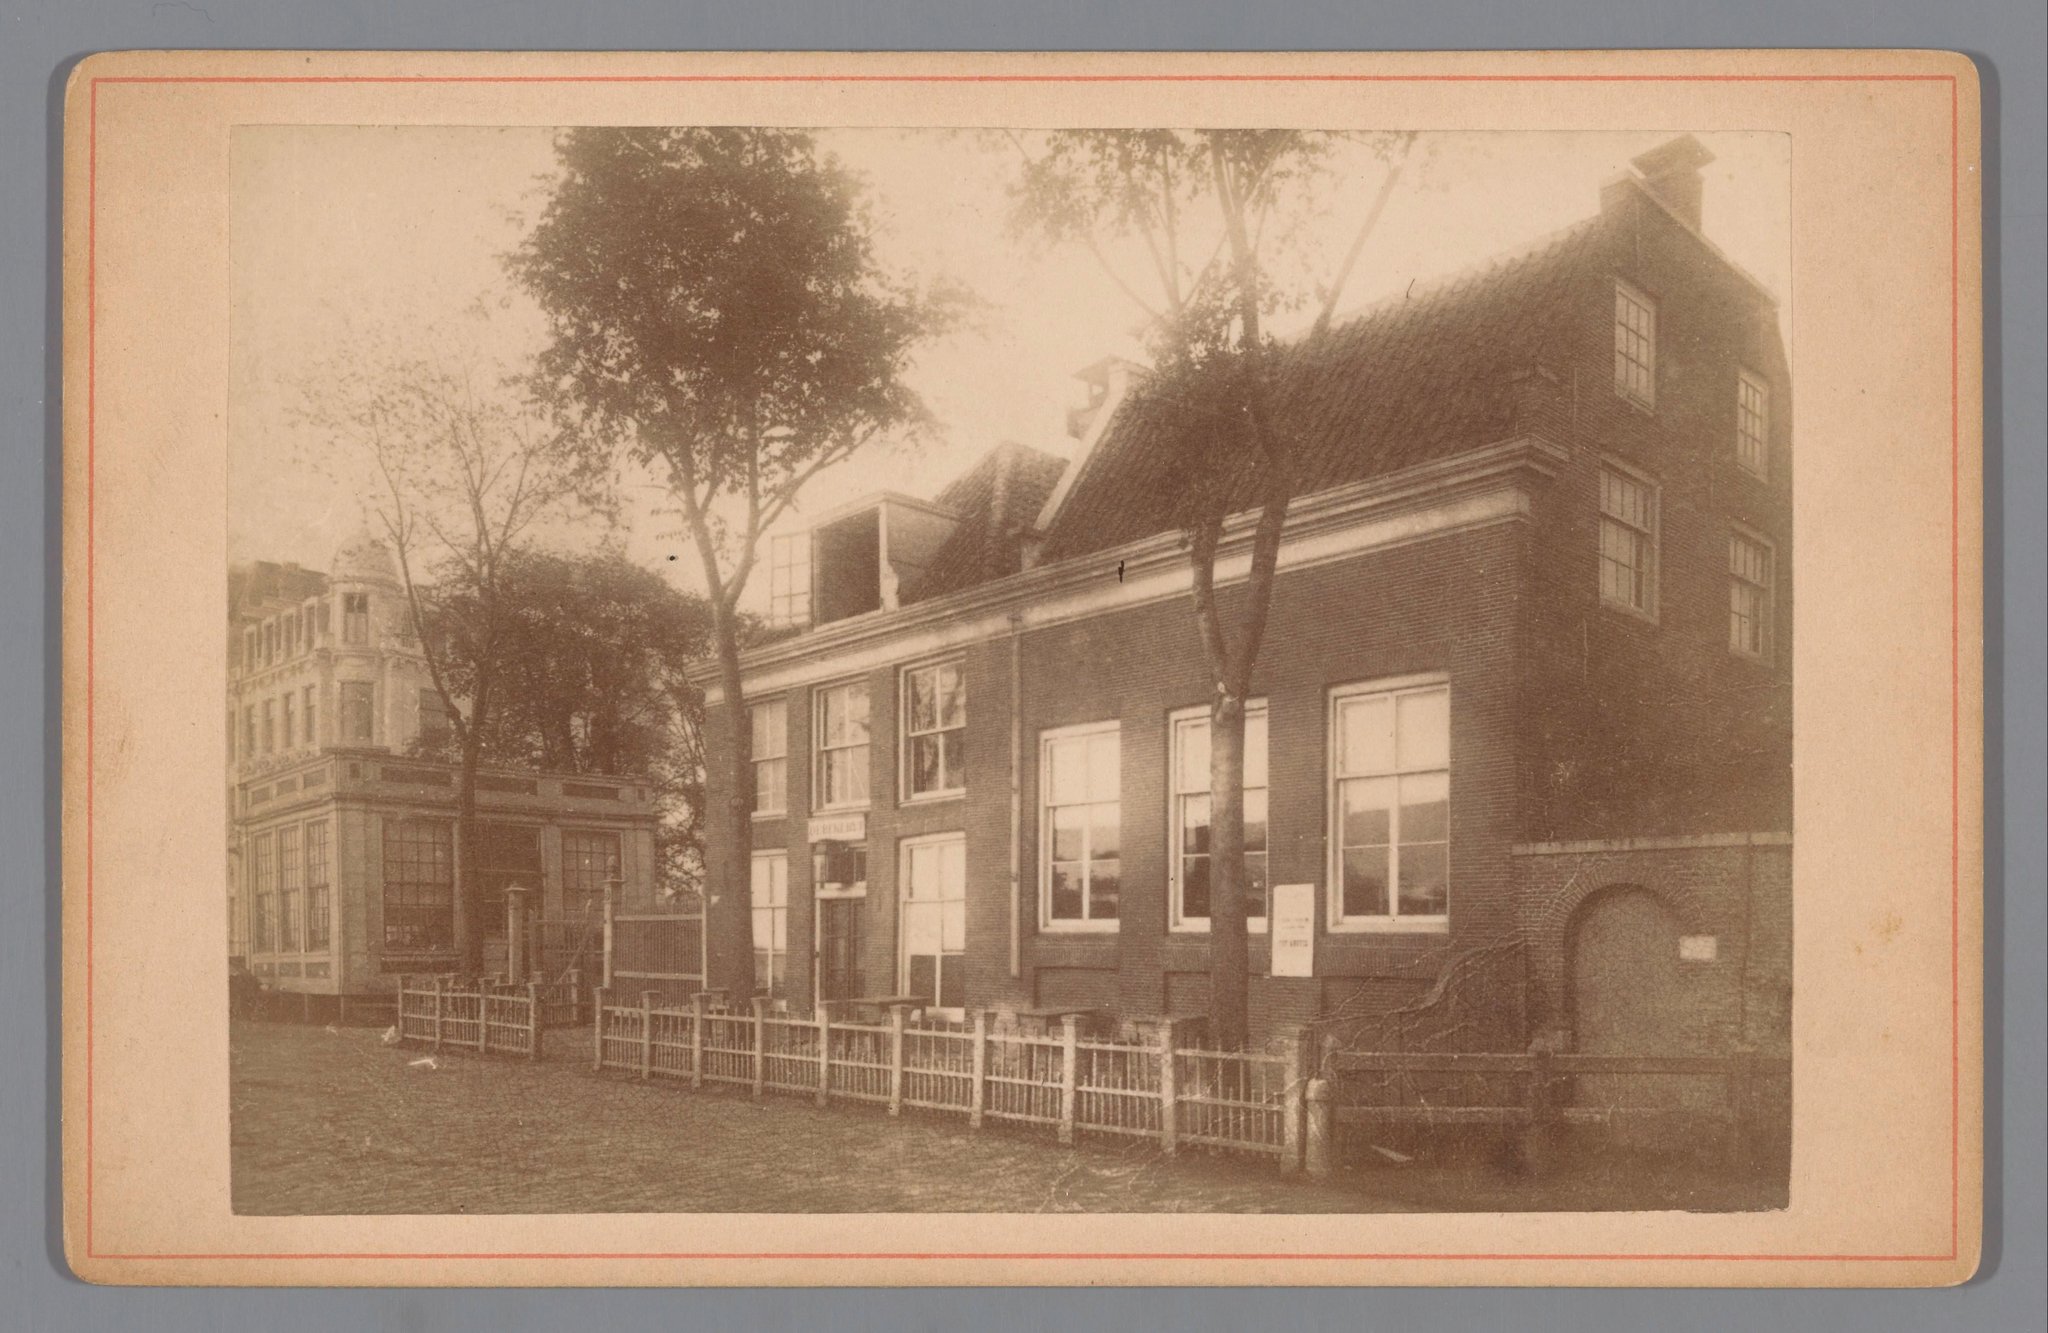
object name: photograph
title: Gezicht op uitspanning de Berebijt aan de Amsteldijk te Amsterdam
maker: paul henri jean reynet de la rue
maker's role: boekhandelaar, drukkerij, fotograaf, lijstenmaker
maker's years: 1839-1927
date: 1850-1900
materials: cardboard, photographic support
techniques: albumen print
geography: amsterdam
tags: urban housing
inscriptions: inscription: ‘Amsteldijk naar het Zuiden gezien, links de Berebijt (thans garage)’, retailer's mark: ‘P.H.J. REYNET DE LA RUE./ PHOTOGRAFISCHE INRICTING/ EN/ KUNSTHANDEL/ Utrechtsestraat No. 35, AMSTERDAM./ (...)’, inscription: ‘de Berebijt’